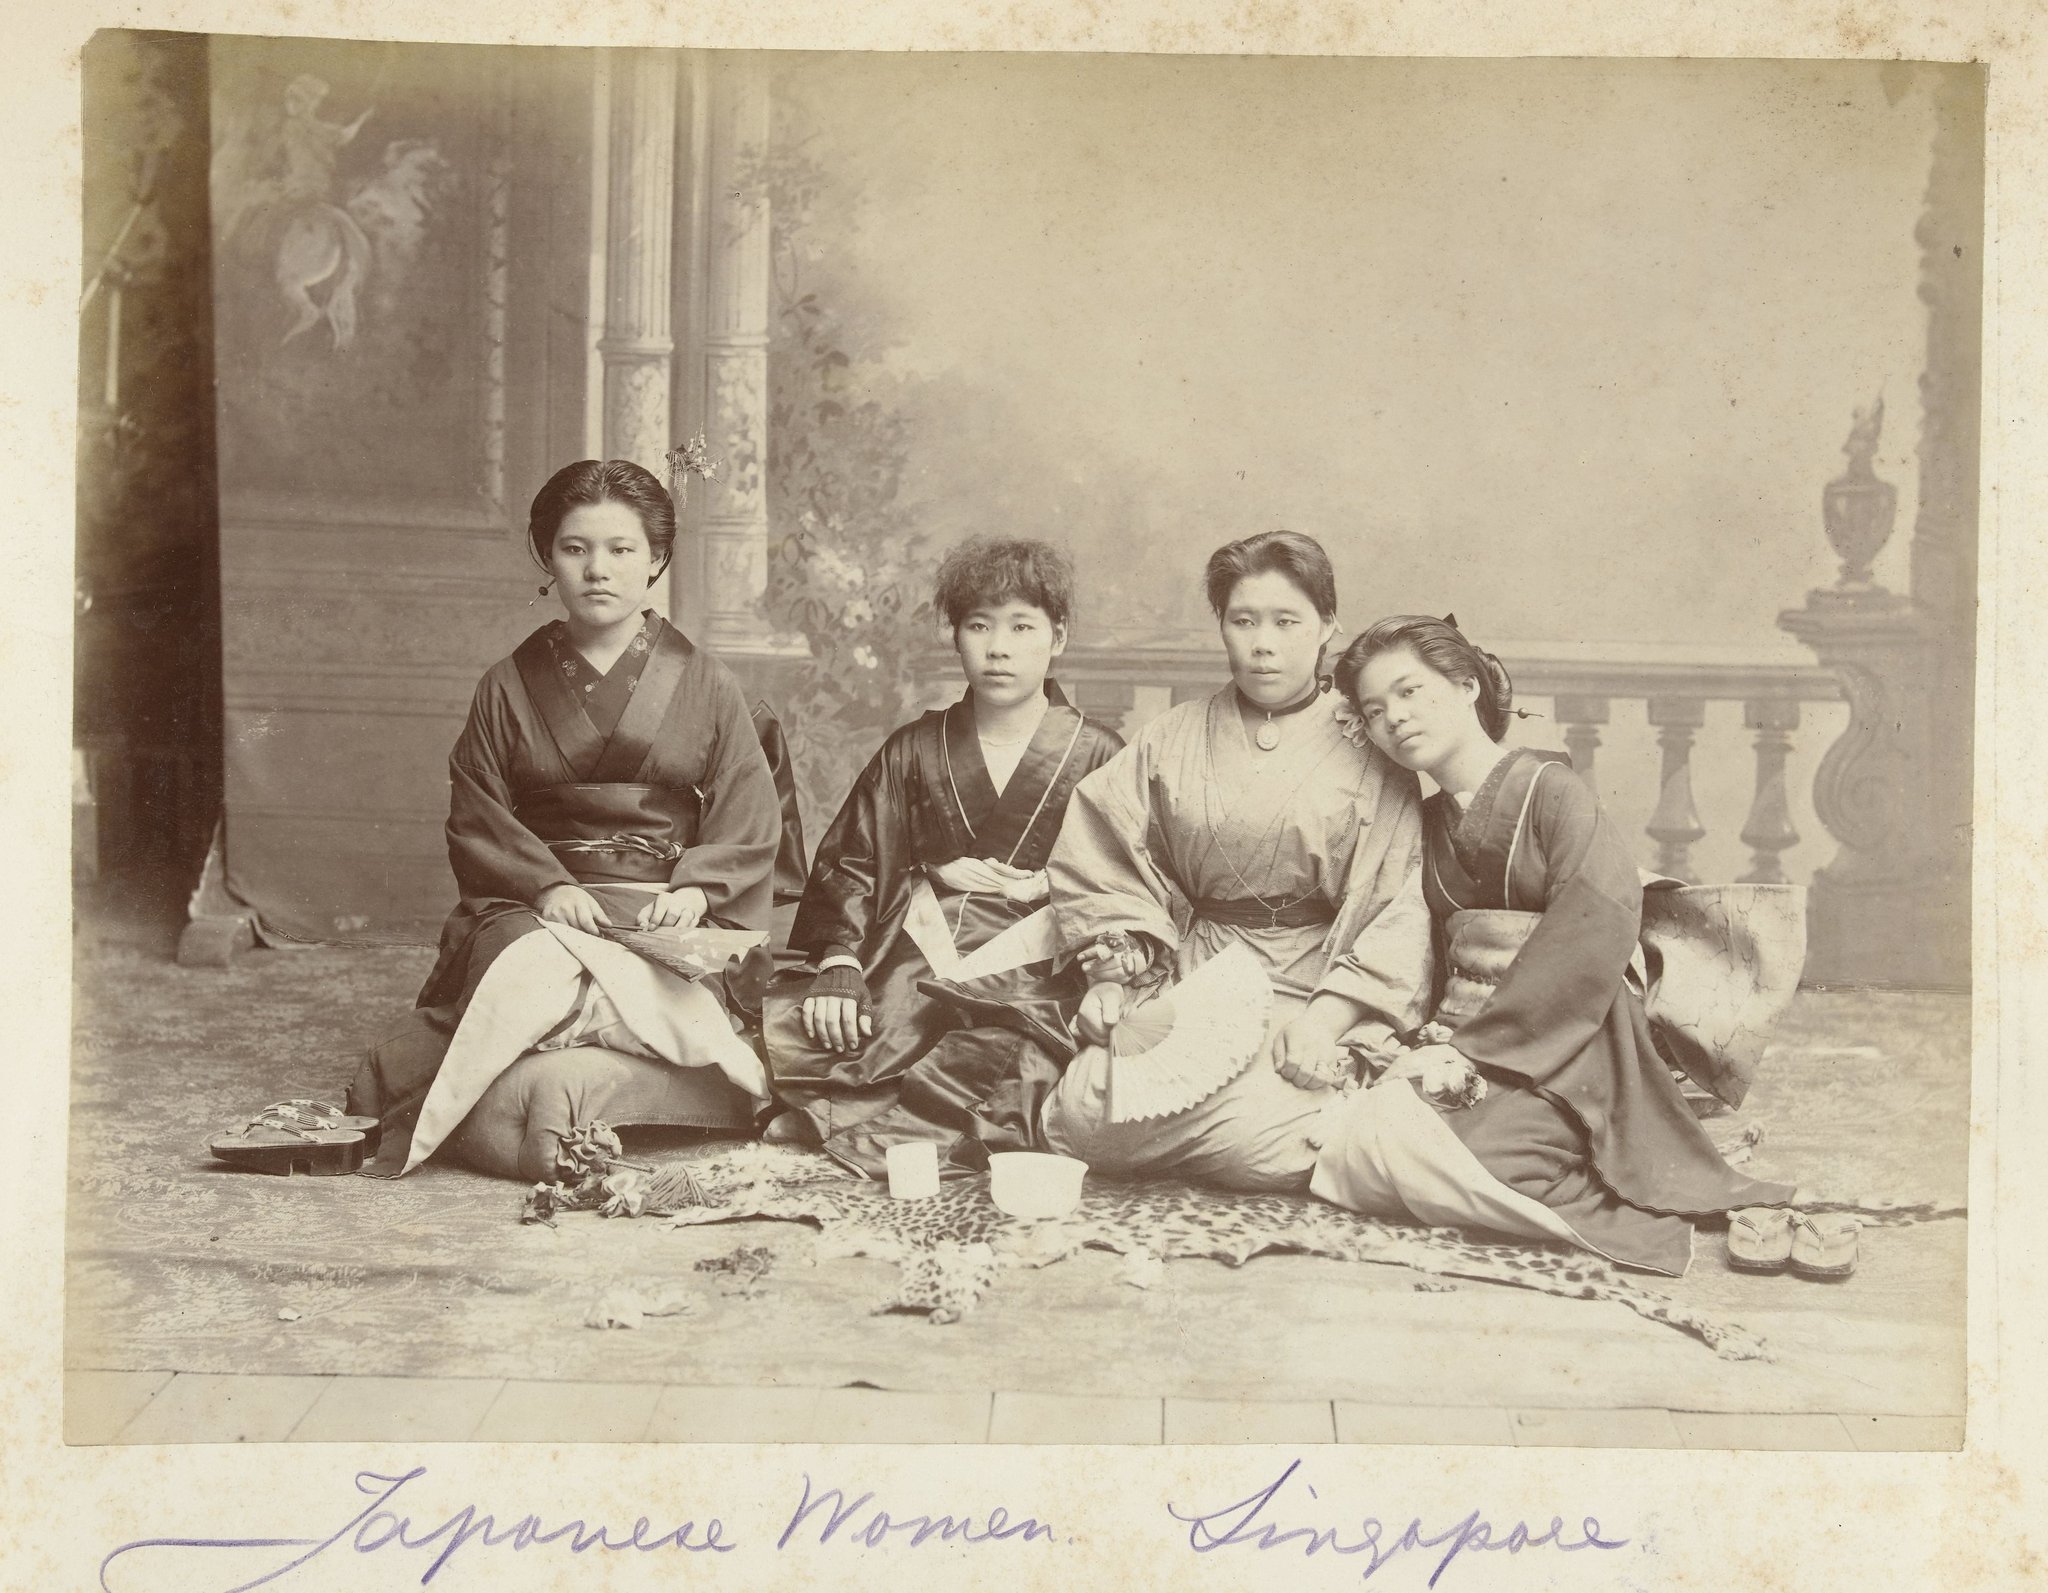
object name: photograph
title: Studioportret van vier japanse vrouwen in kimono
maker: Anonymous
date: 1890-1910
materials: cardboard, paper, photographic support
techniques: gelatin silver print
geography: netherlands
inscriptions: caption: ‘Japanese women, Singapore’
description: De vrouwen dragen kimono's en zitten geknield op de grond op een panter vel. De tweede dame van rechts heeft een waaier in haar hand.